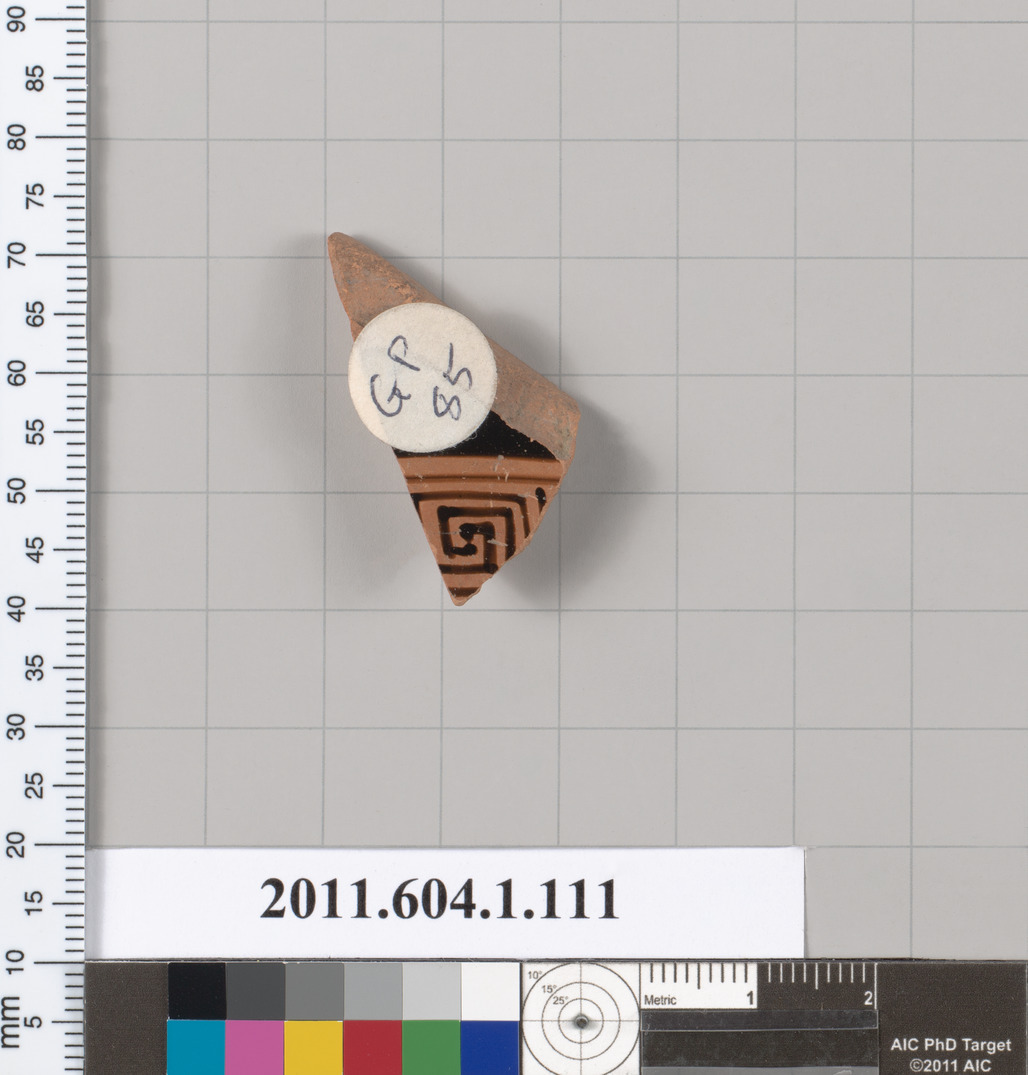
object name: kylix fragment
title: Terracotta fragment of a kylix (drinking cup)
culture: greek, attic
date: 470-450 BCE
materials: terracotta